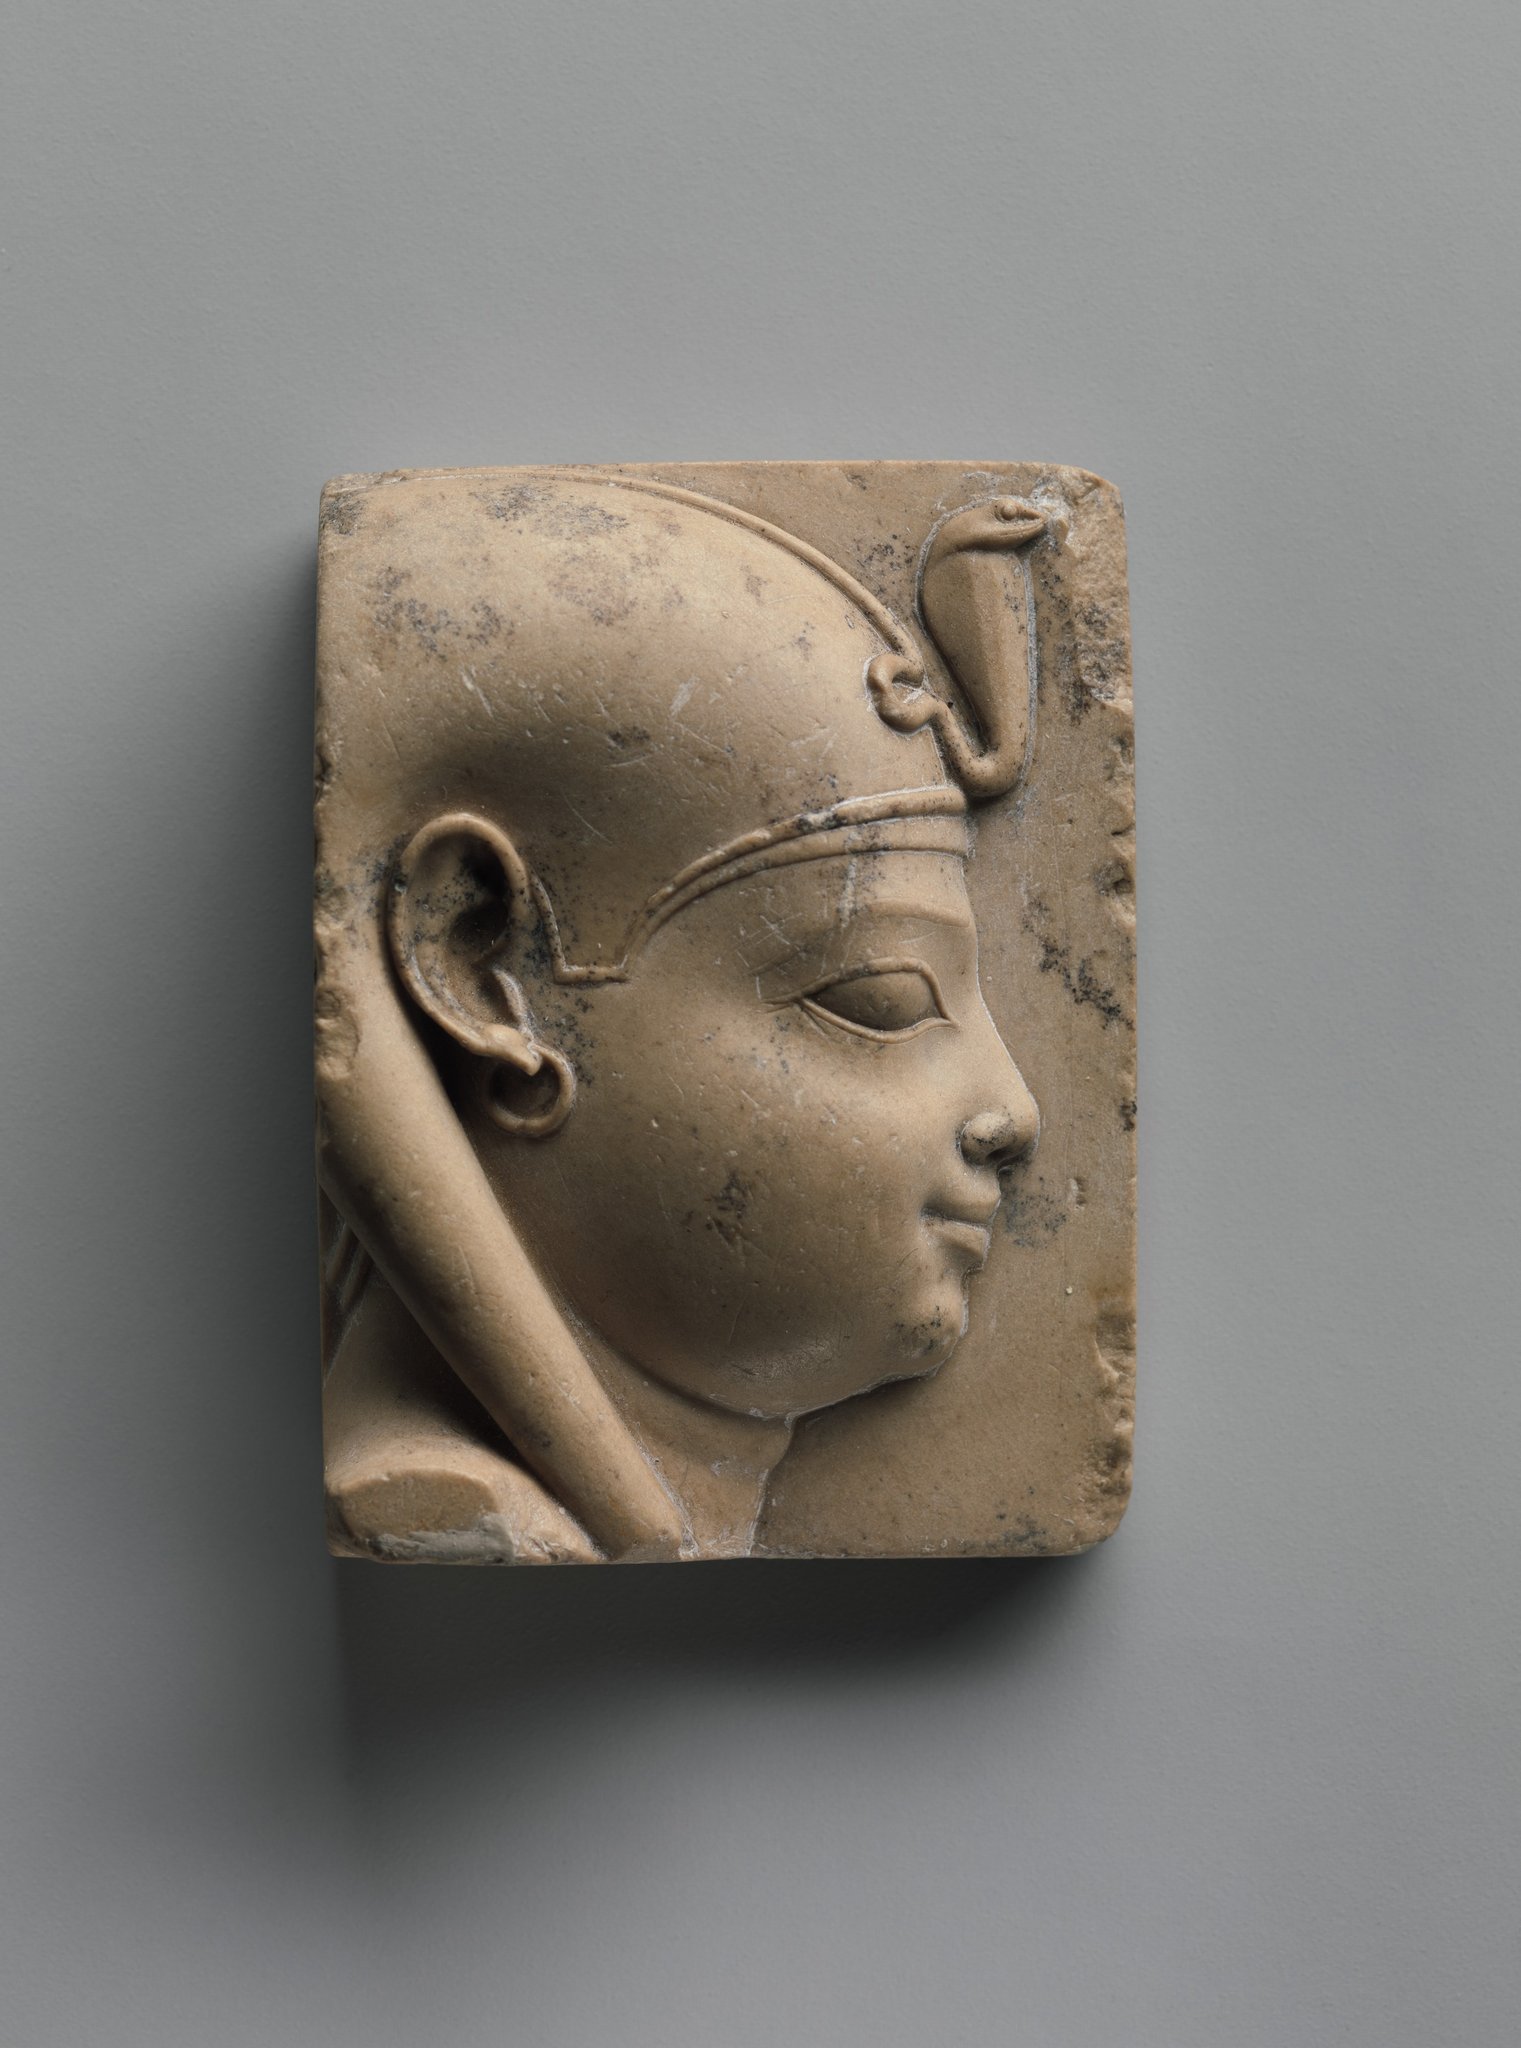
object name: sculptor's model votive, relief bust of divine royal child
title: Plaque with bust of a divine child with earring (Ihy?)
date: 400-30 BCE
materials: limestone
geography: egypt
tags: children